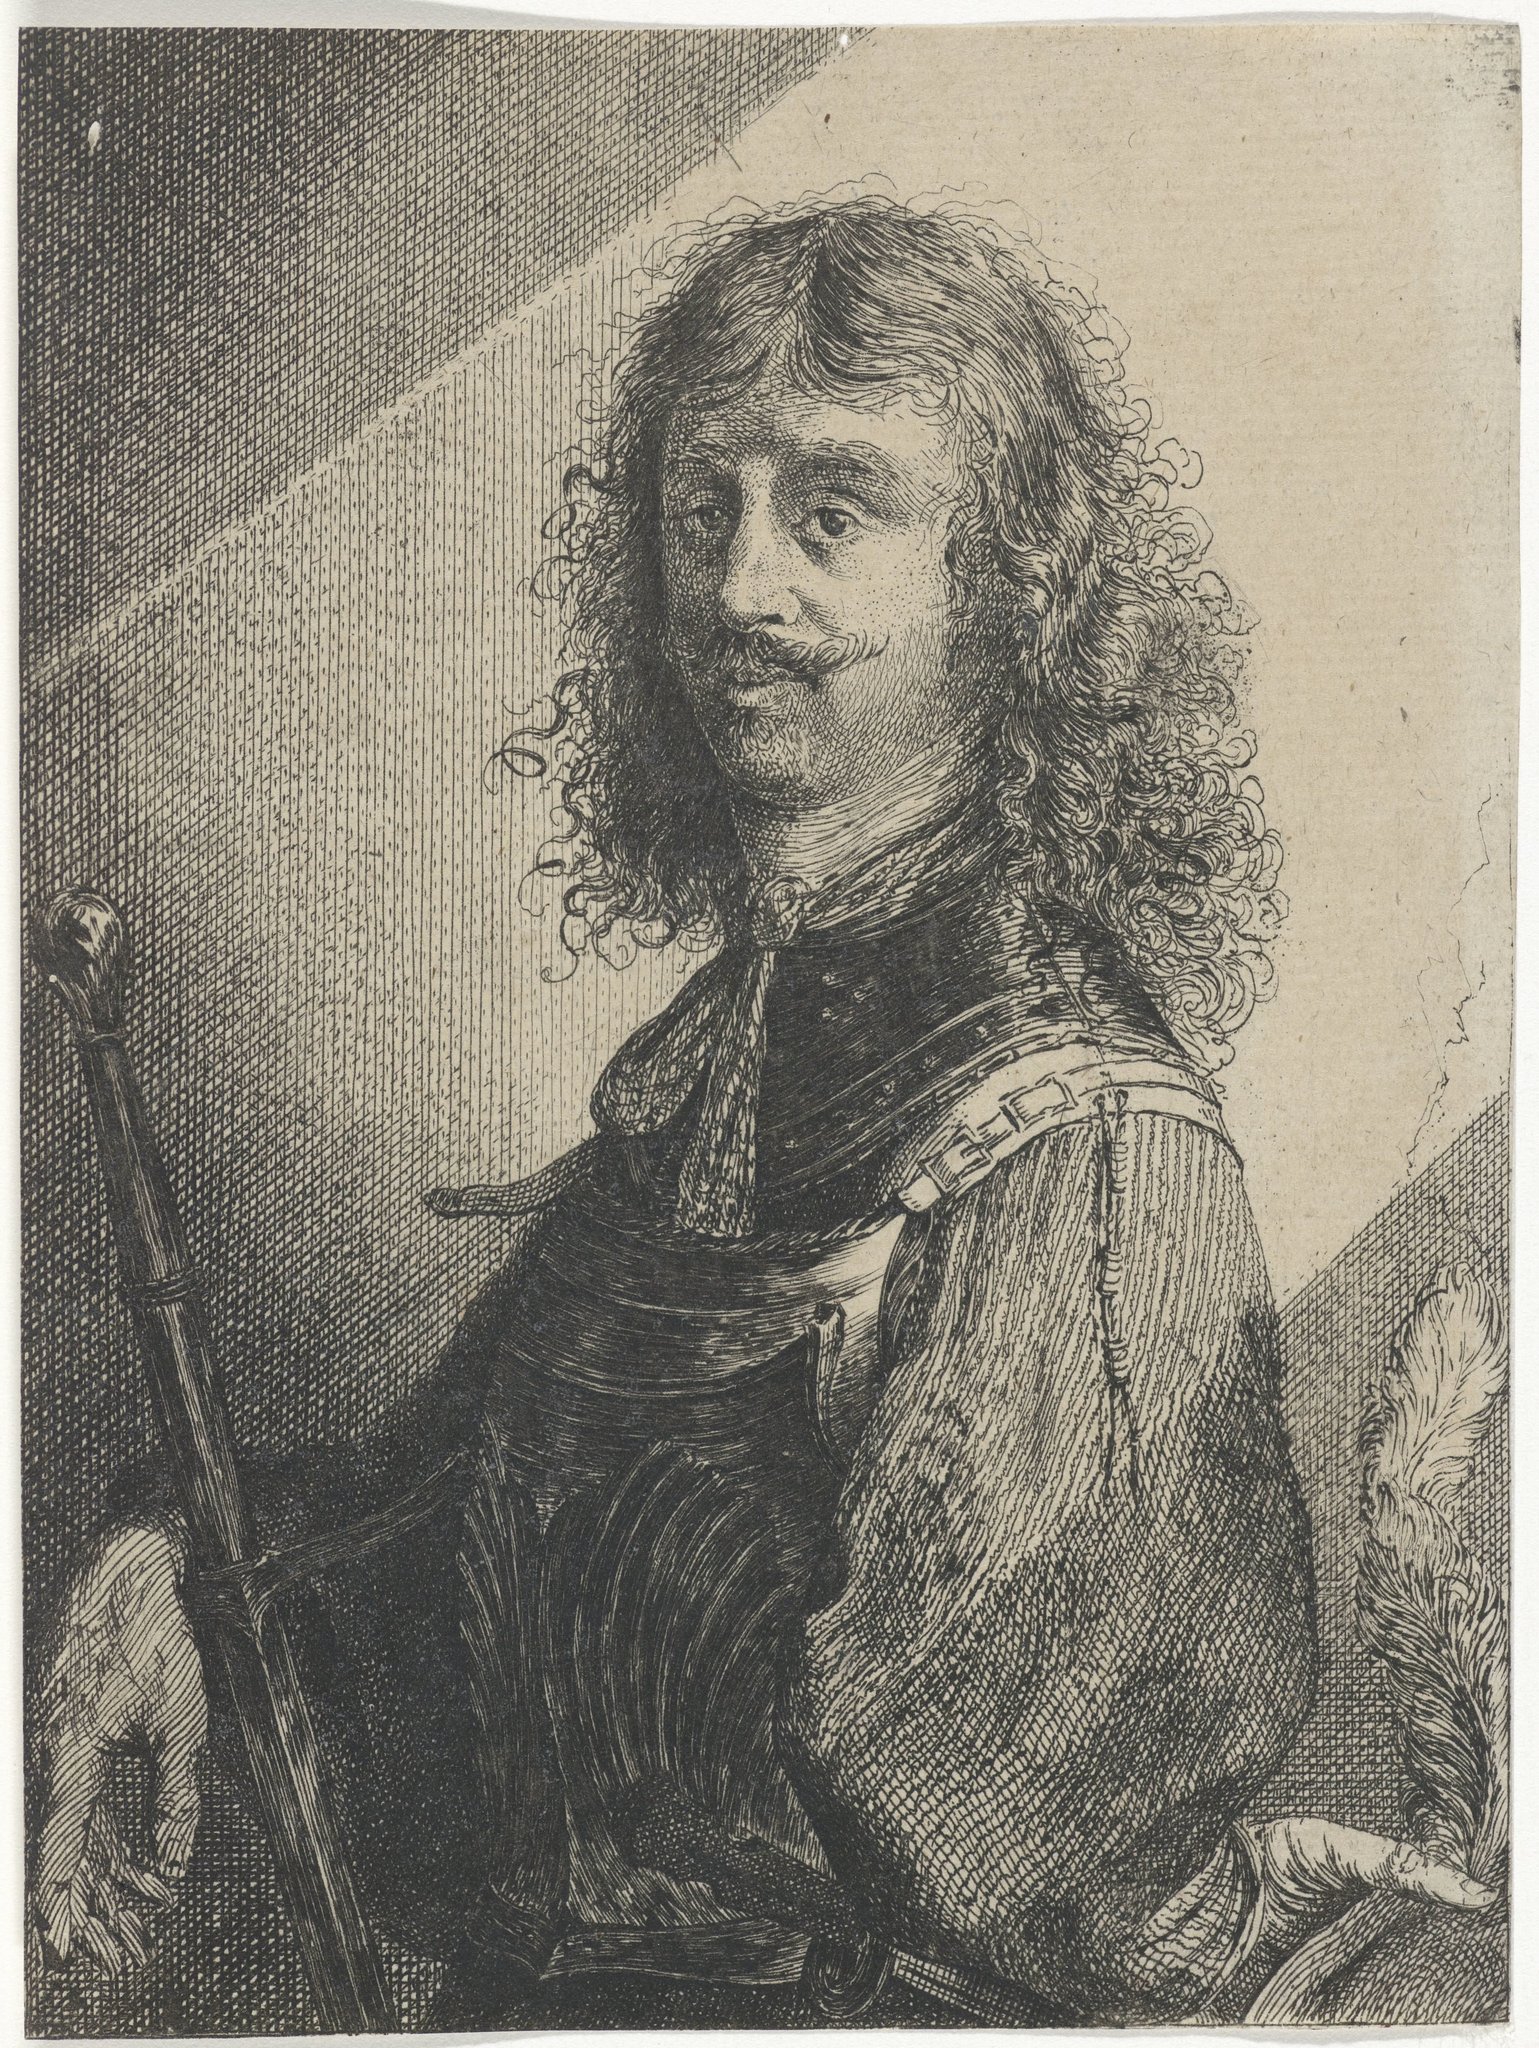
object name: print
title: Man in wapenrusting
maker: pieter rottermondt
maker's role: draughtsman, print maker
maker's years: -1706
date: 1639-1706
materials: paper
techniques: engraving, etching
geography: northern netherlands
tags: the soldier; the soldier's life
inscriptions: collector's mark: Lugt 240